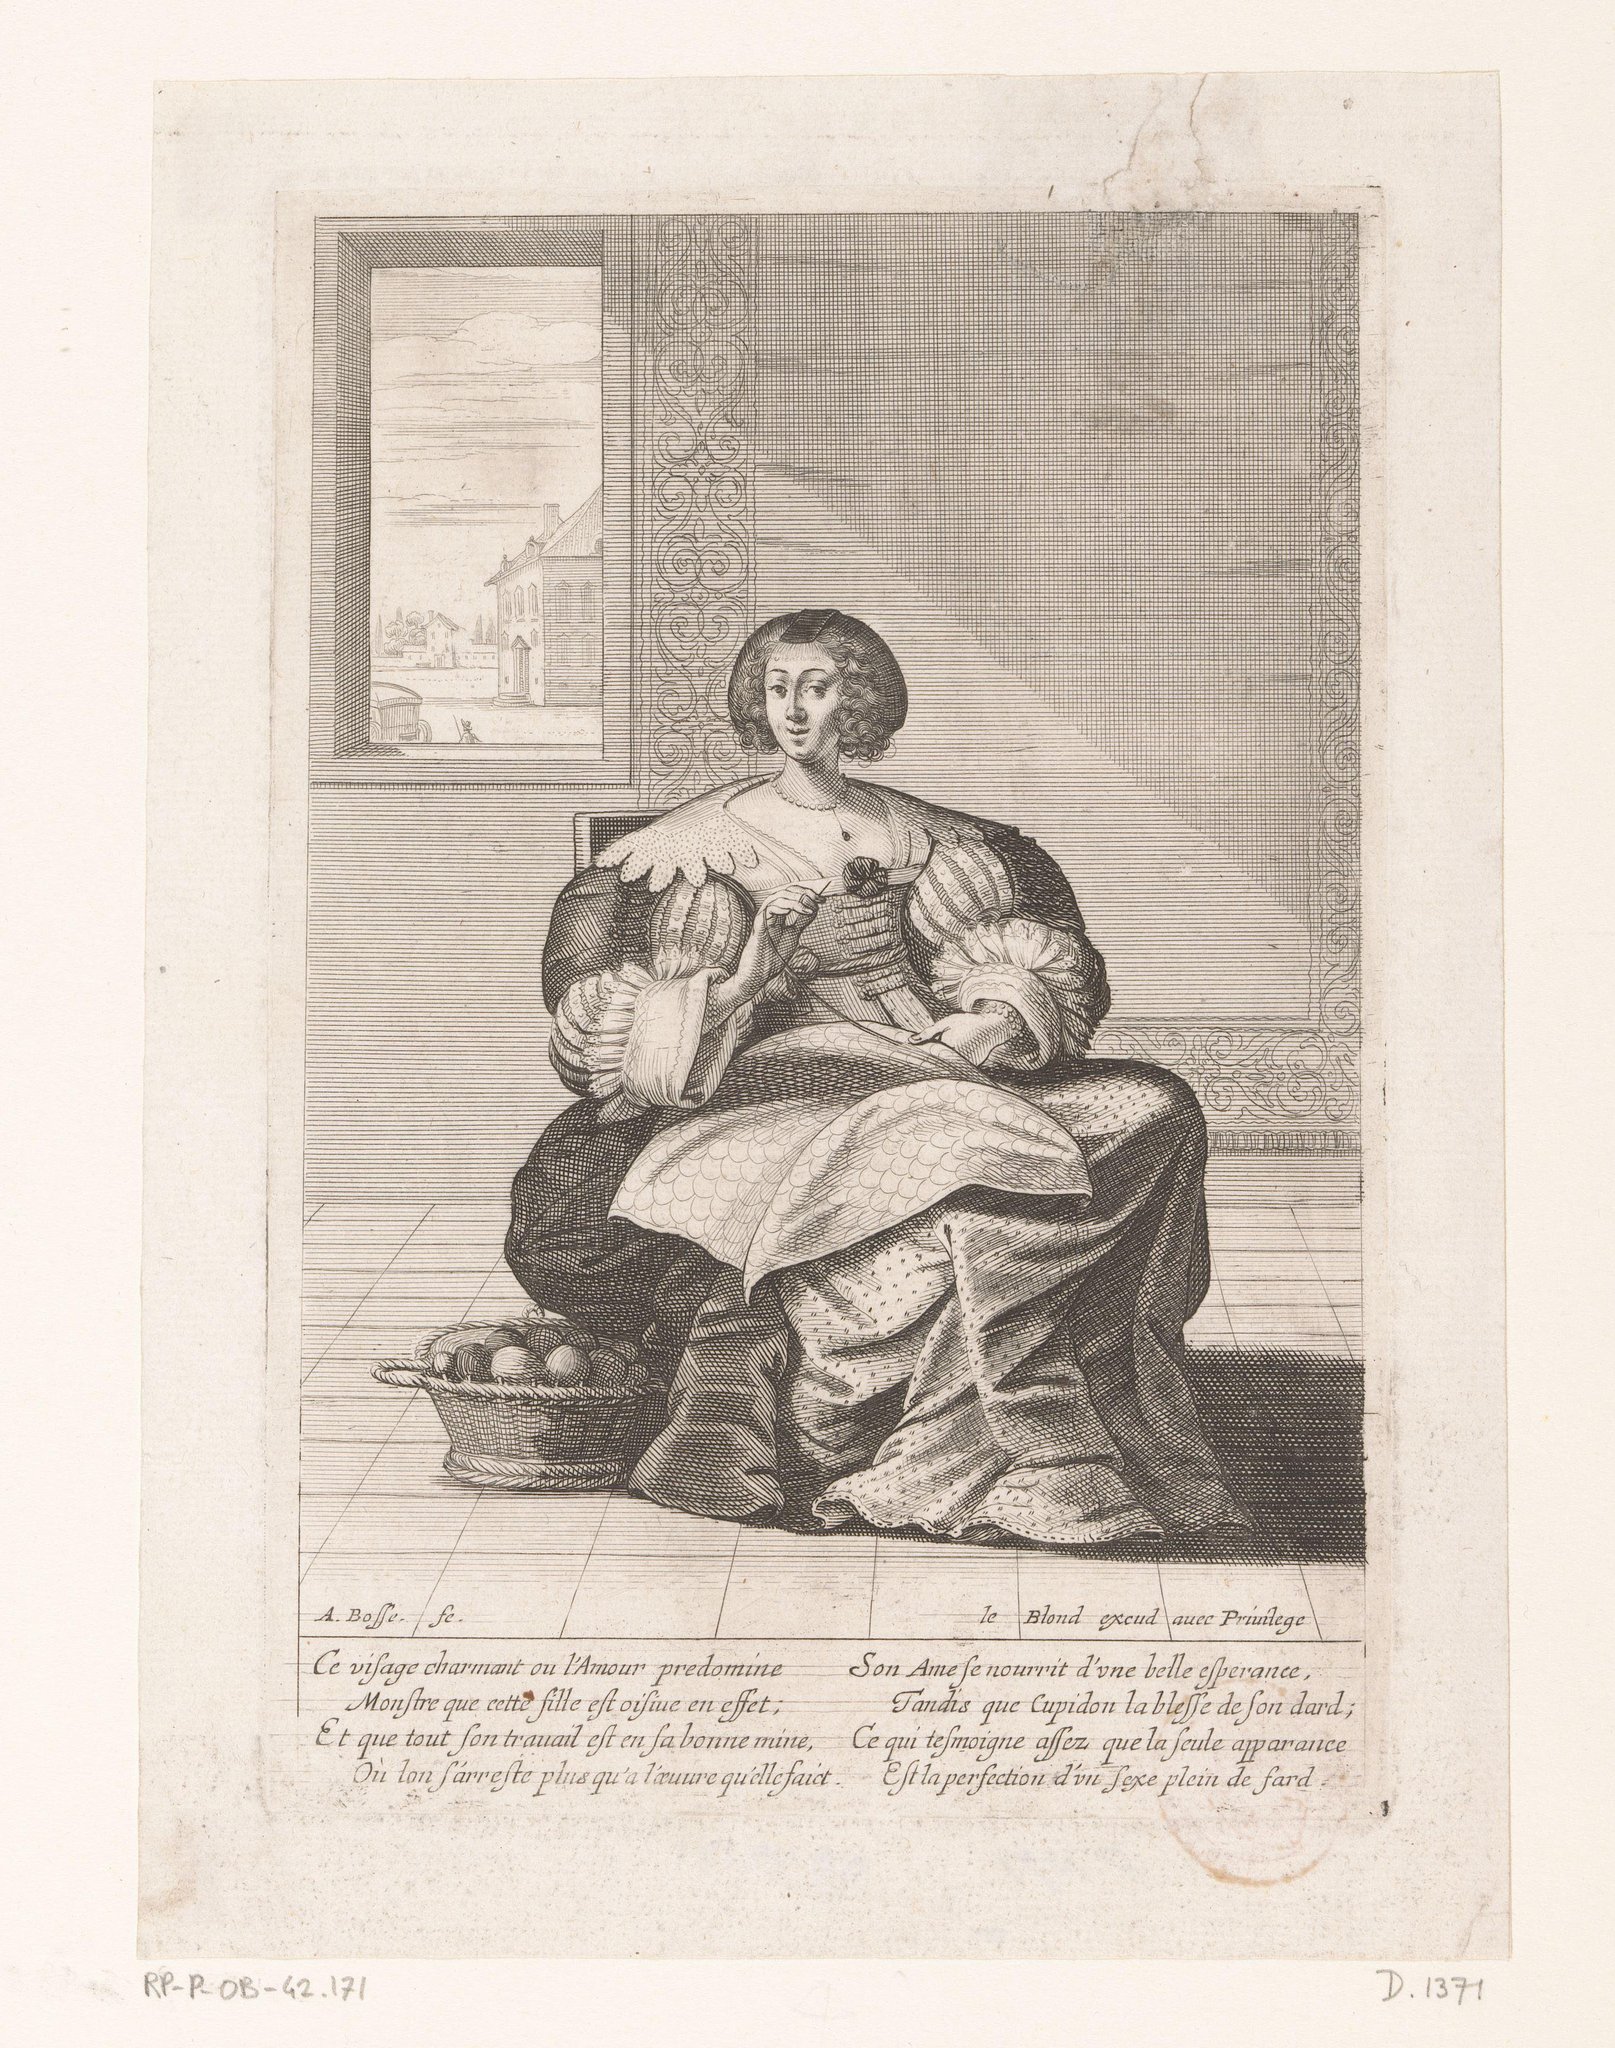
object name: print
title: Bordurende vrouw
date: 1630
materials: paper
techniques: engraving, etching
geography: paris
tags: (ball of) yarn, dress, gown (+ women's clothes), (other forms of) needlework, e.g.: crocheting, knitting, embroidering, embroidery (ornamentation)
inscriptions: collector's mark: Lugt 240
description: Zittende dame in een vertrek, van voren gezien, modieus gekleed volgens de Franse mode van ca. 1630-'35. De vrouw borduurt of naait aan een kleed. Naast haar een mand met kluwen garen.